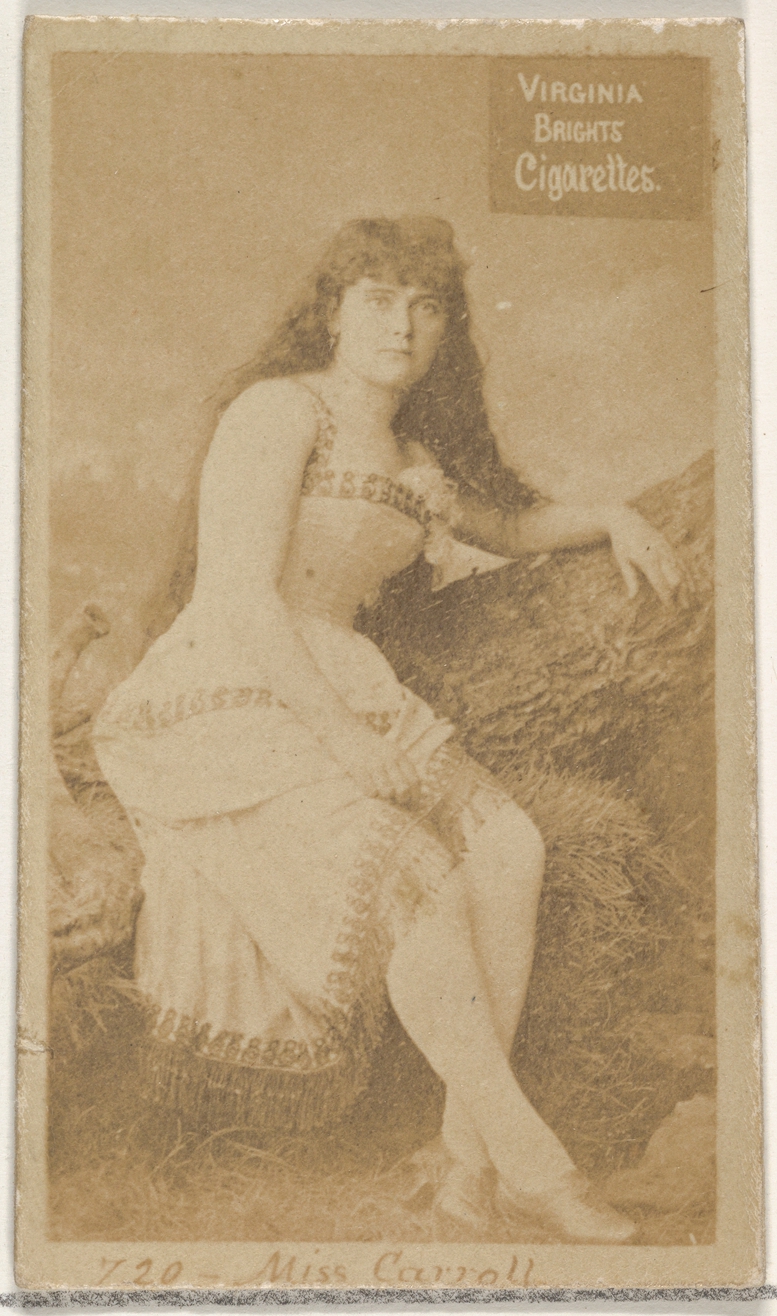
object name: photograph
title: Card 720, Miss Carroll, from the Actors and Actresses series (N45, Type 2) for Virginia Brights Cigarettes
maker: allen & ginter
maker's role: publisher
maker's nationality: american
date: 1888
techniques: albumen silver print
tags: portraits,women,actresses